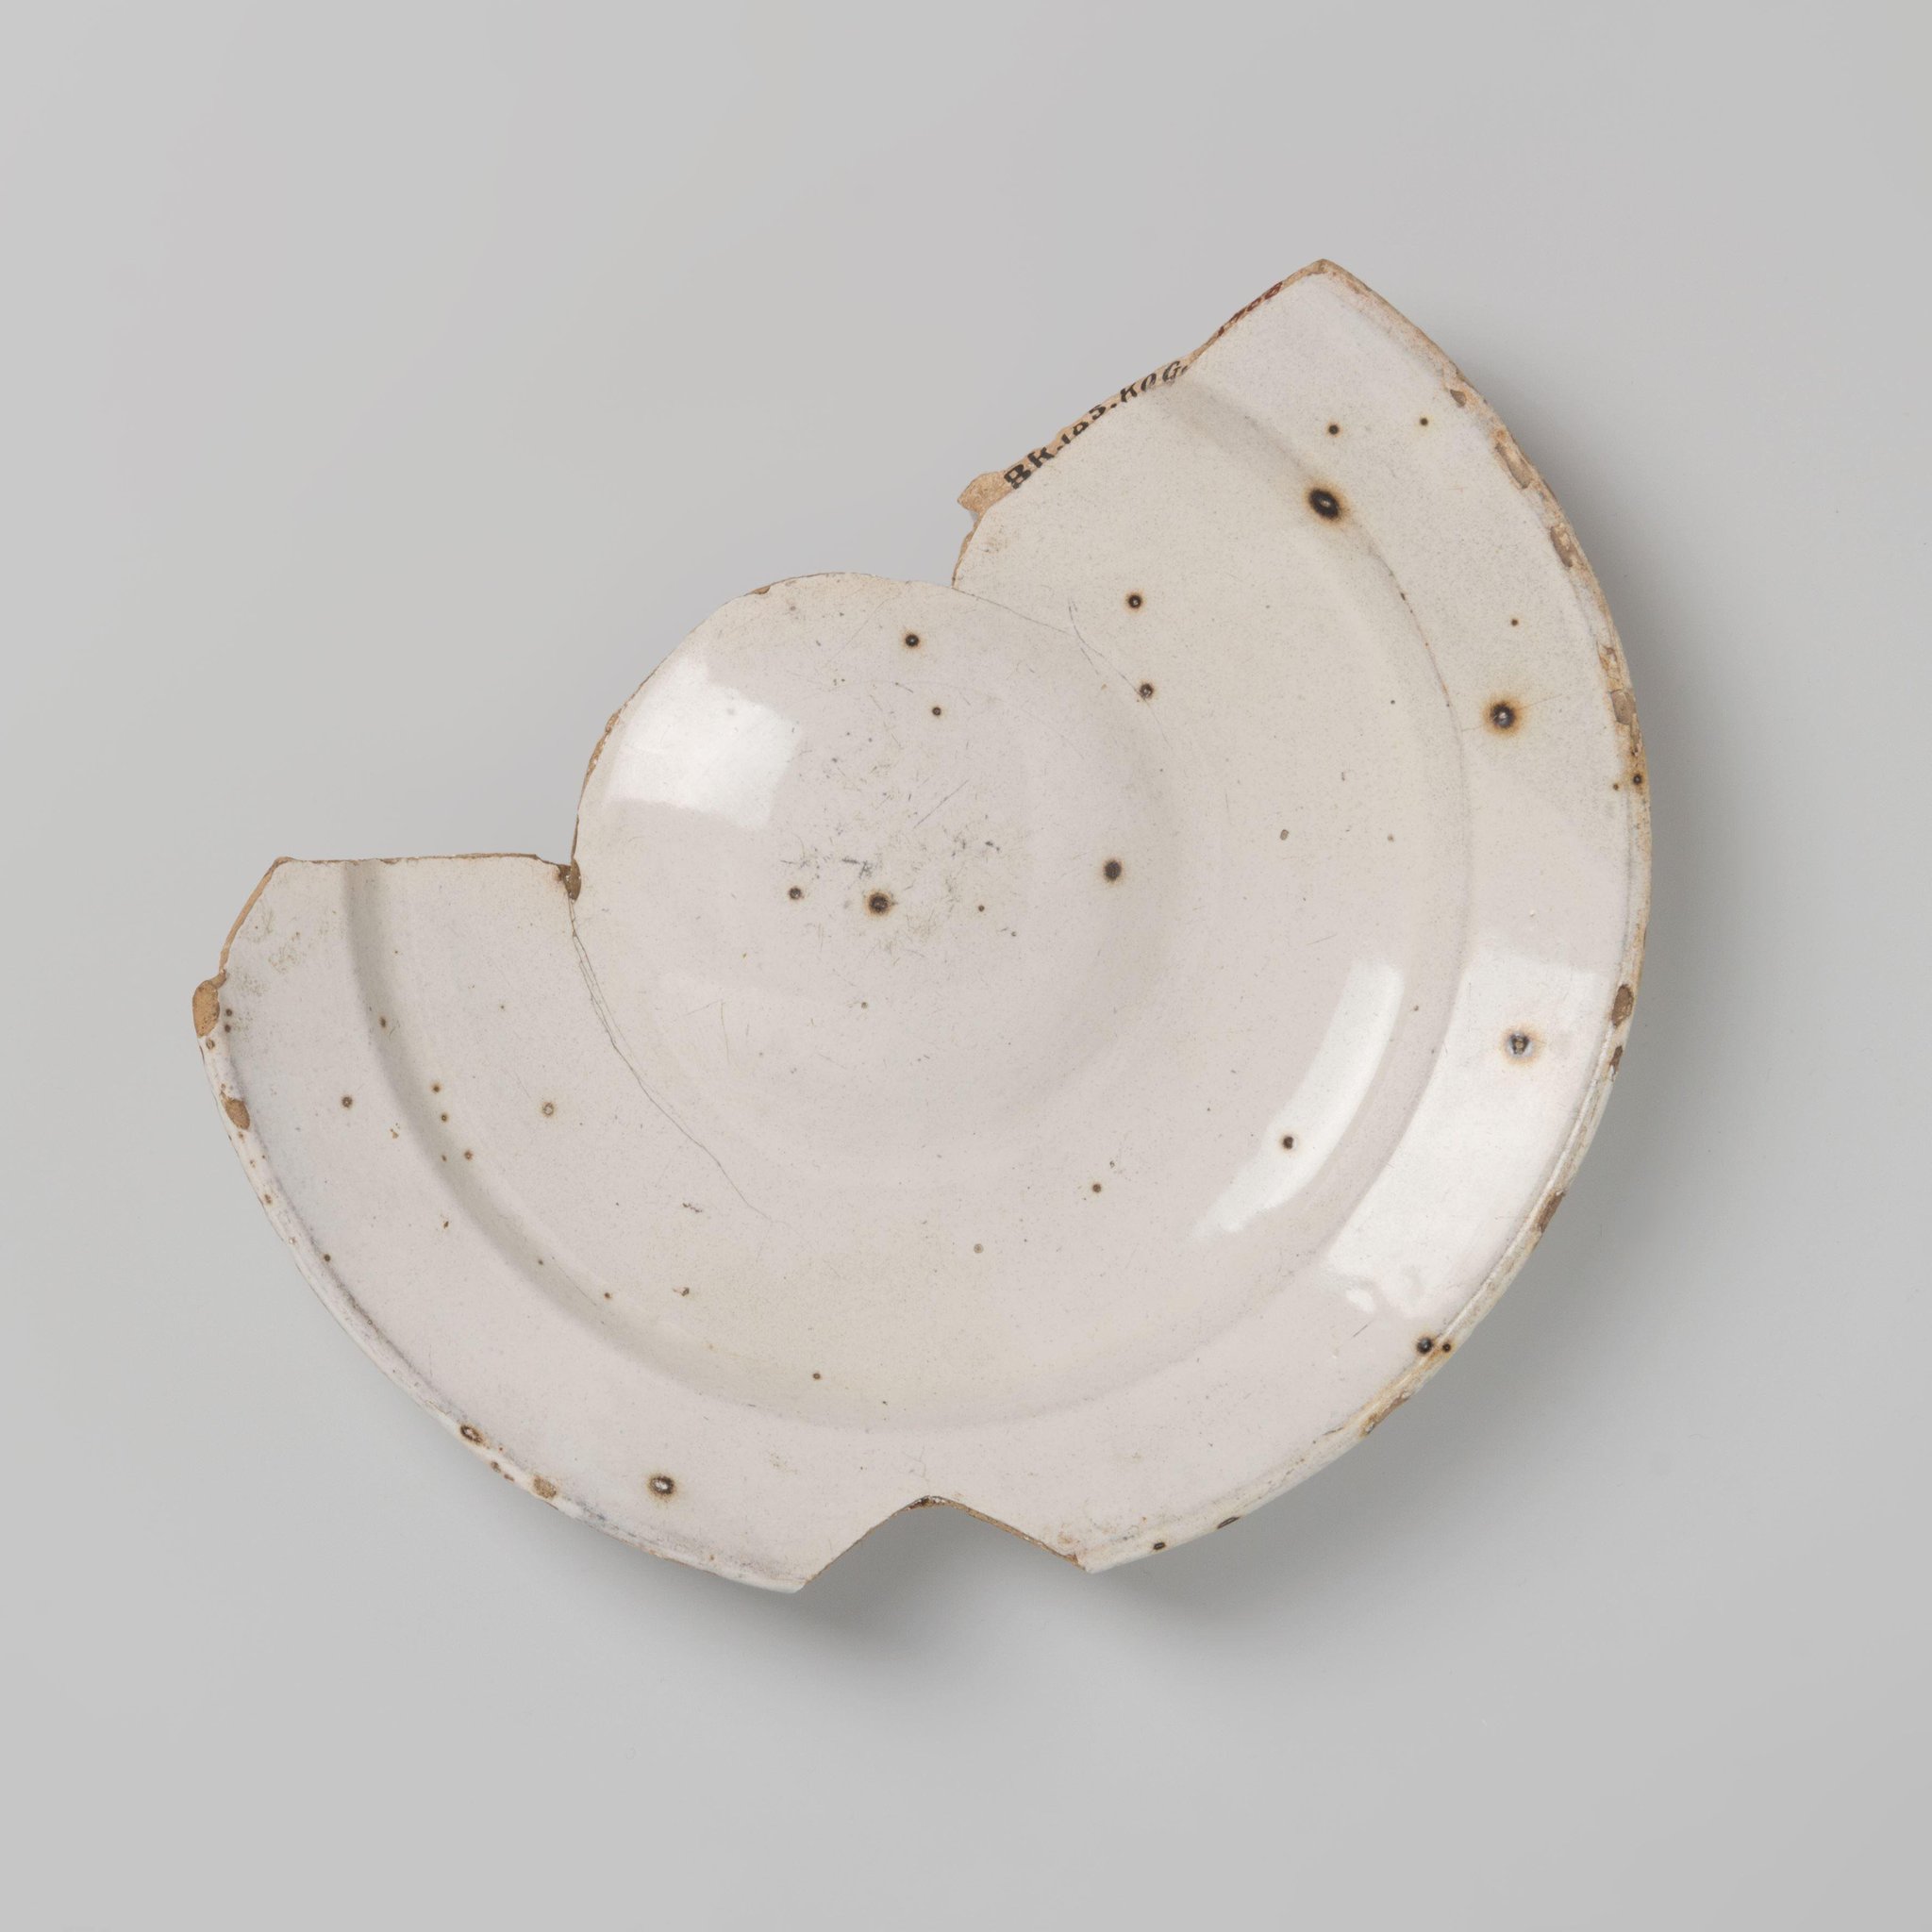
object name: plate dish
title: Bord van aardewerk, geheel voorzien van wit tinglazuur, beschadigd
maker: Anonymous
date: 1500-1799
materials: earthenware, glaze